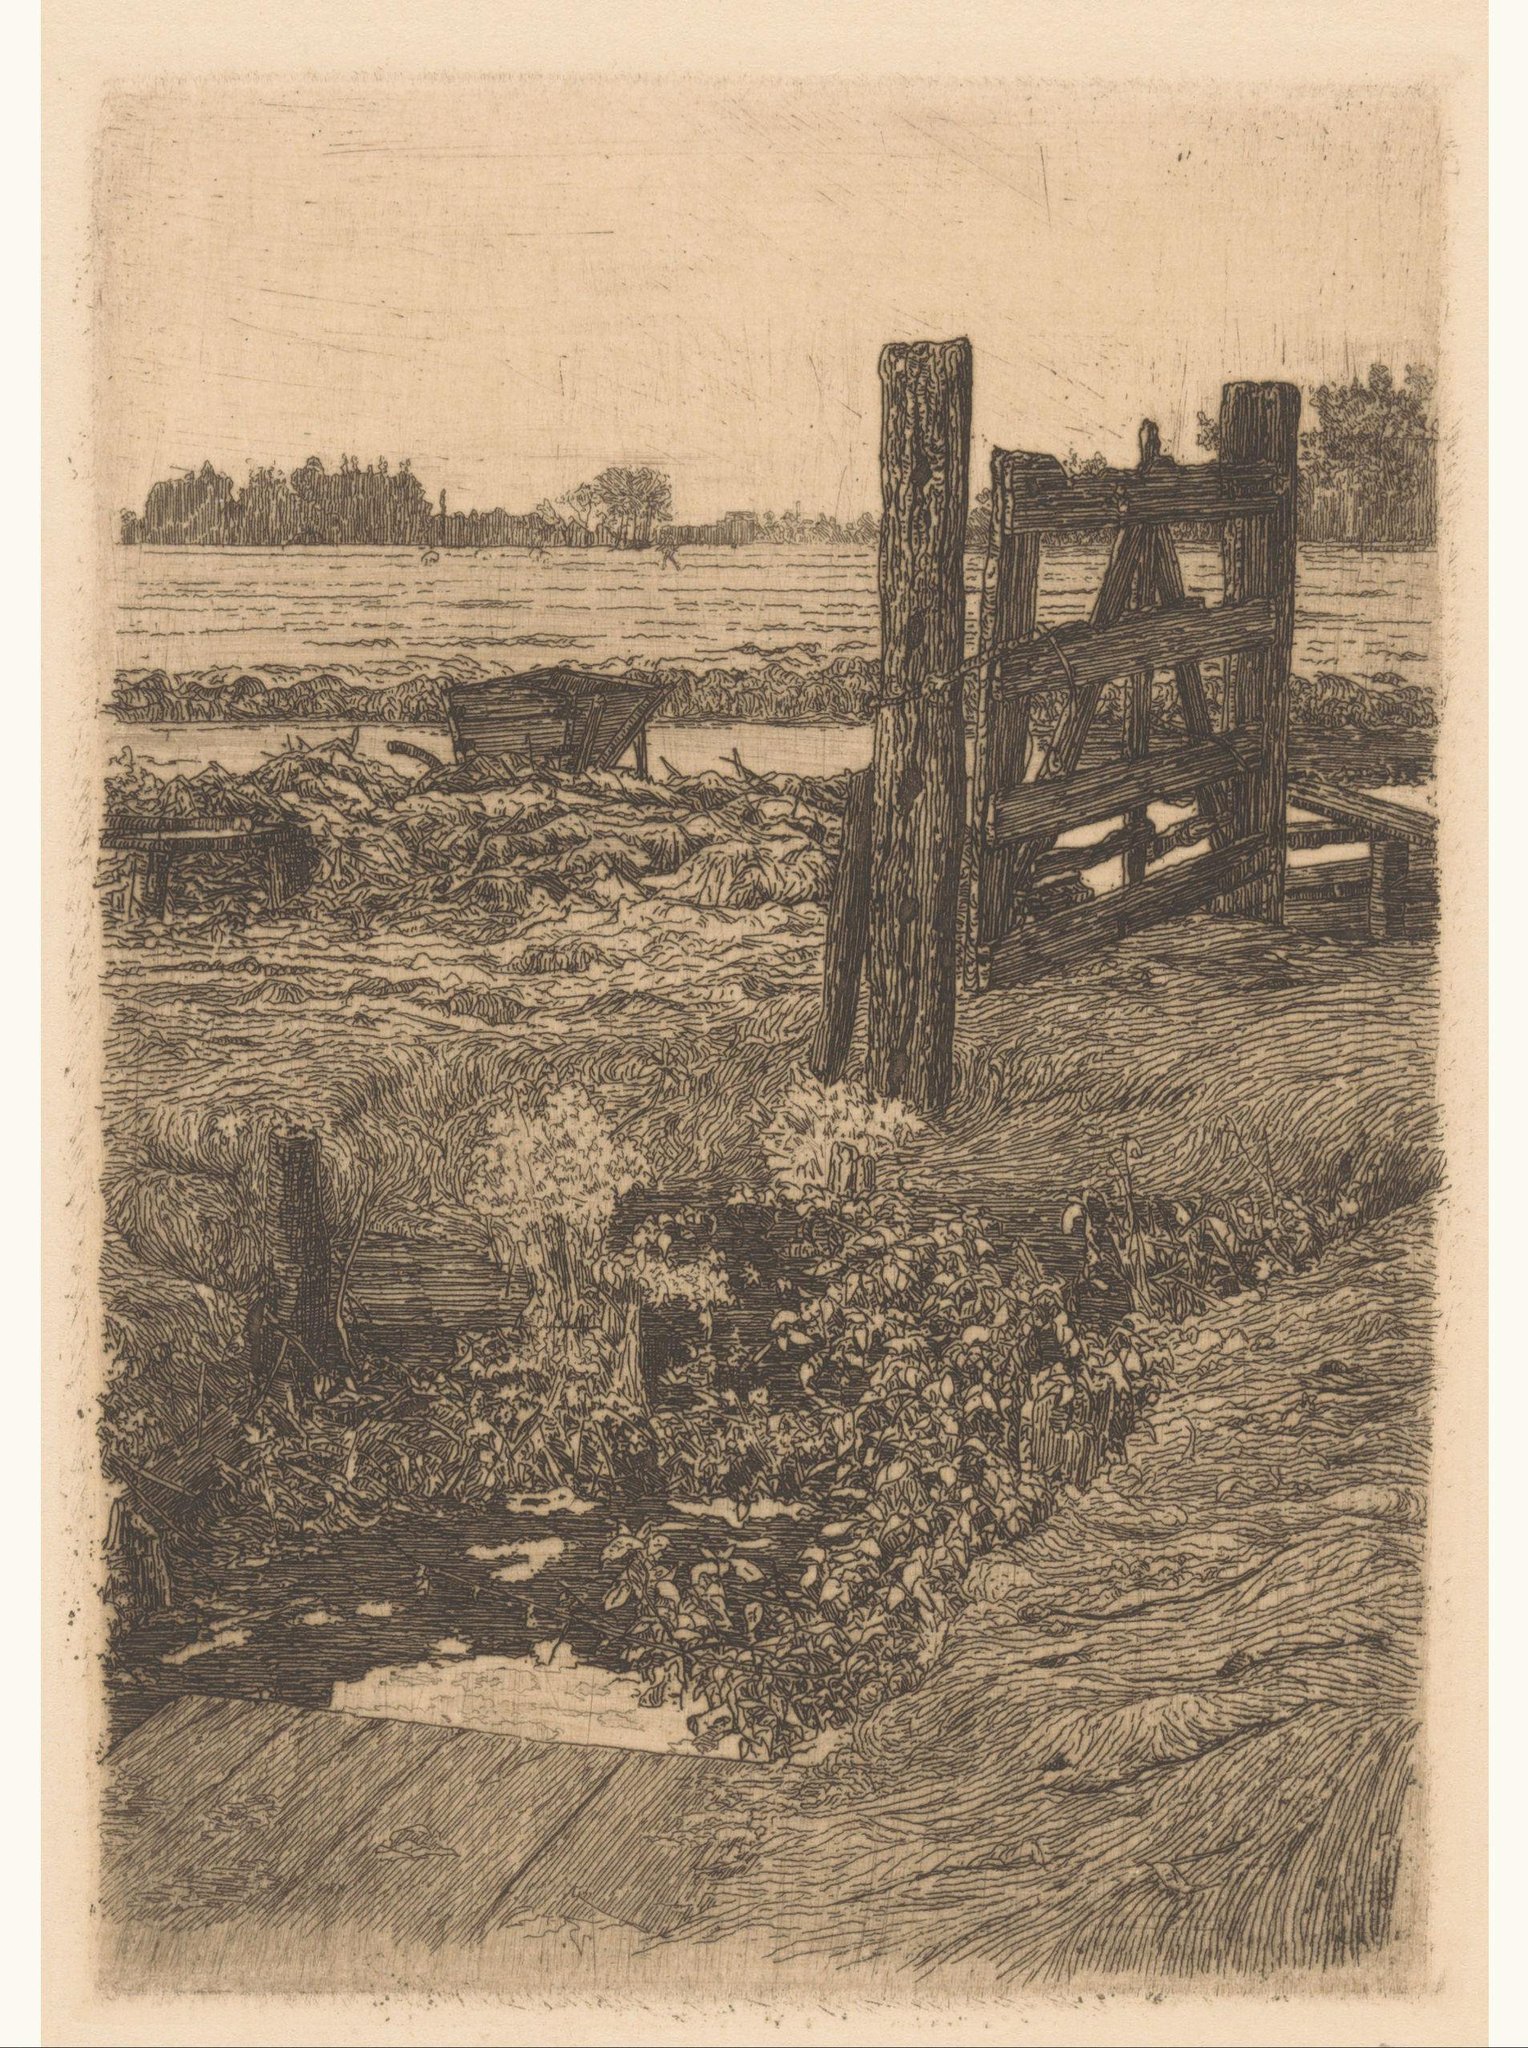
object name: print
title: Hek bij een weiland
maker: johannes henrichs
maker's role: print maker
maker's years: 1882-1954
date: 1908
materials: paper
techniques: etching, intaglio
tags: fence, wall, paling, meadow, pasture, small canal, ditch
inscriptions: collector's mark: Lugt 2228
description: Op de voorgrond een sloot. Achter het weiland nog een sloot.